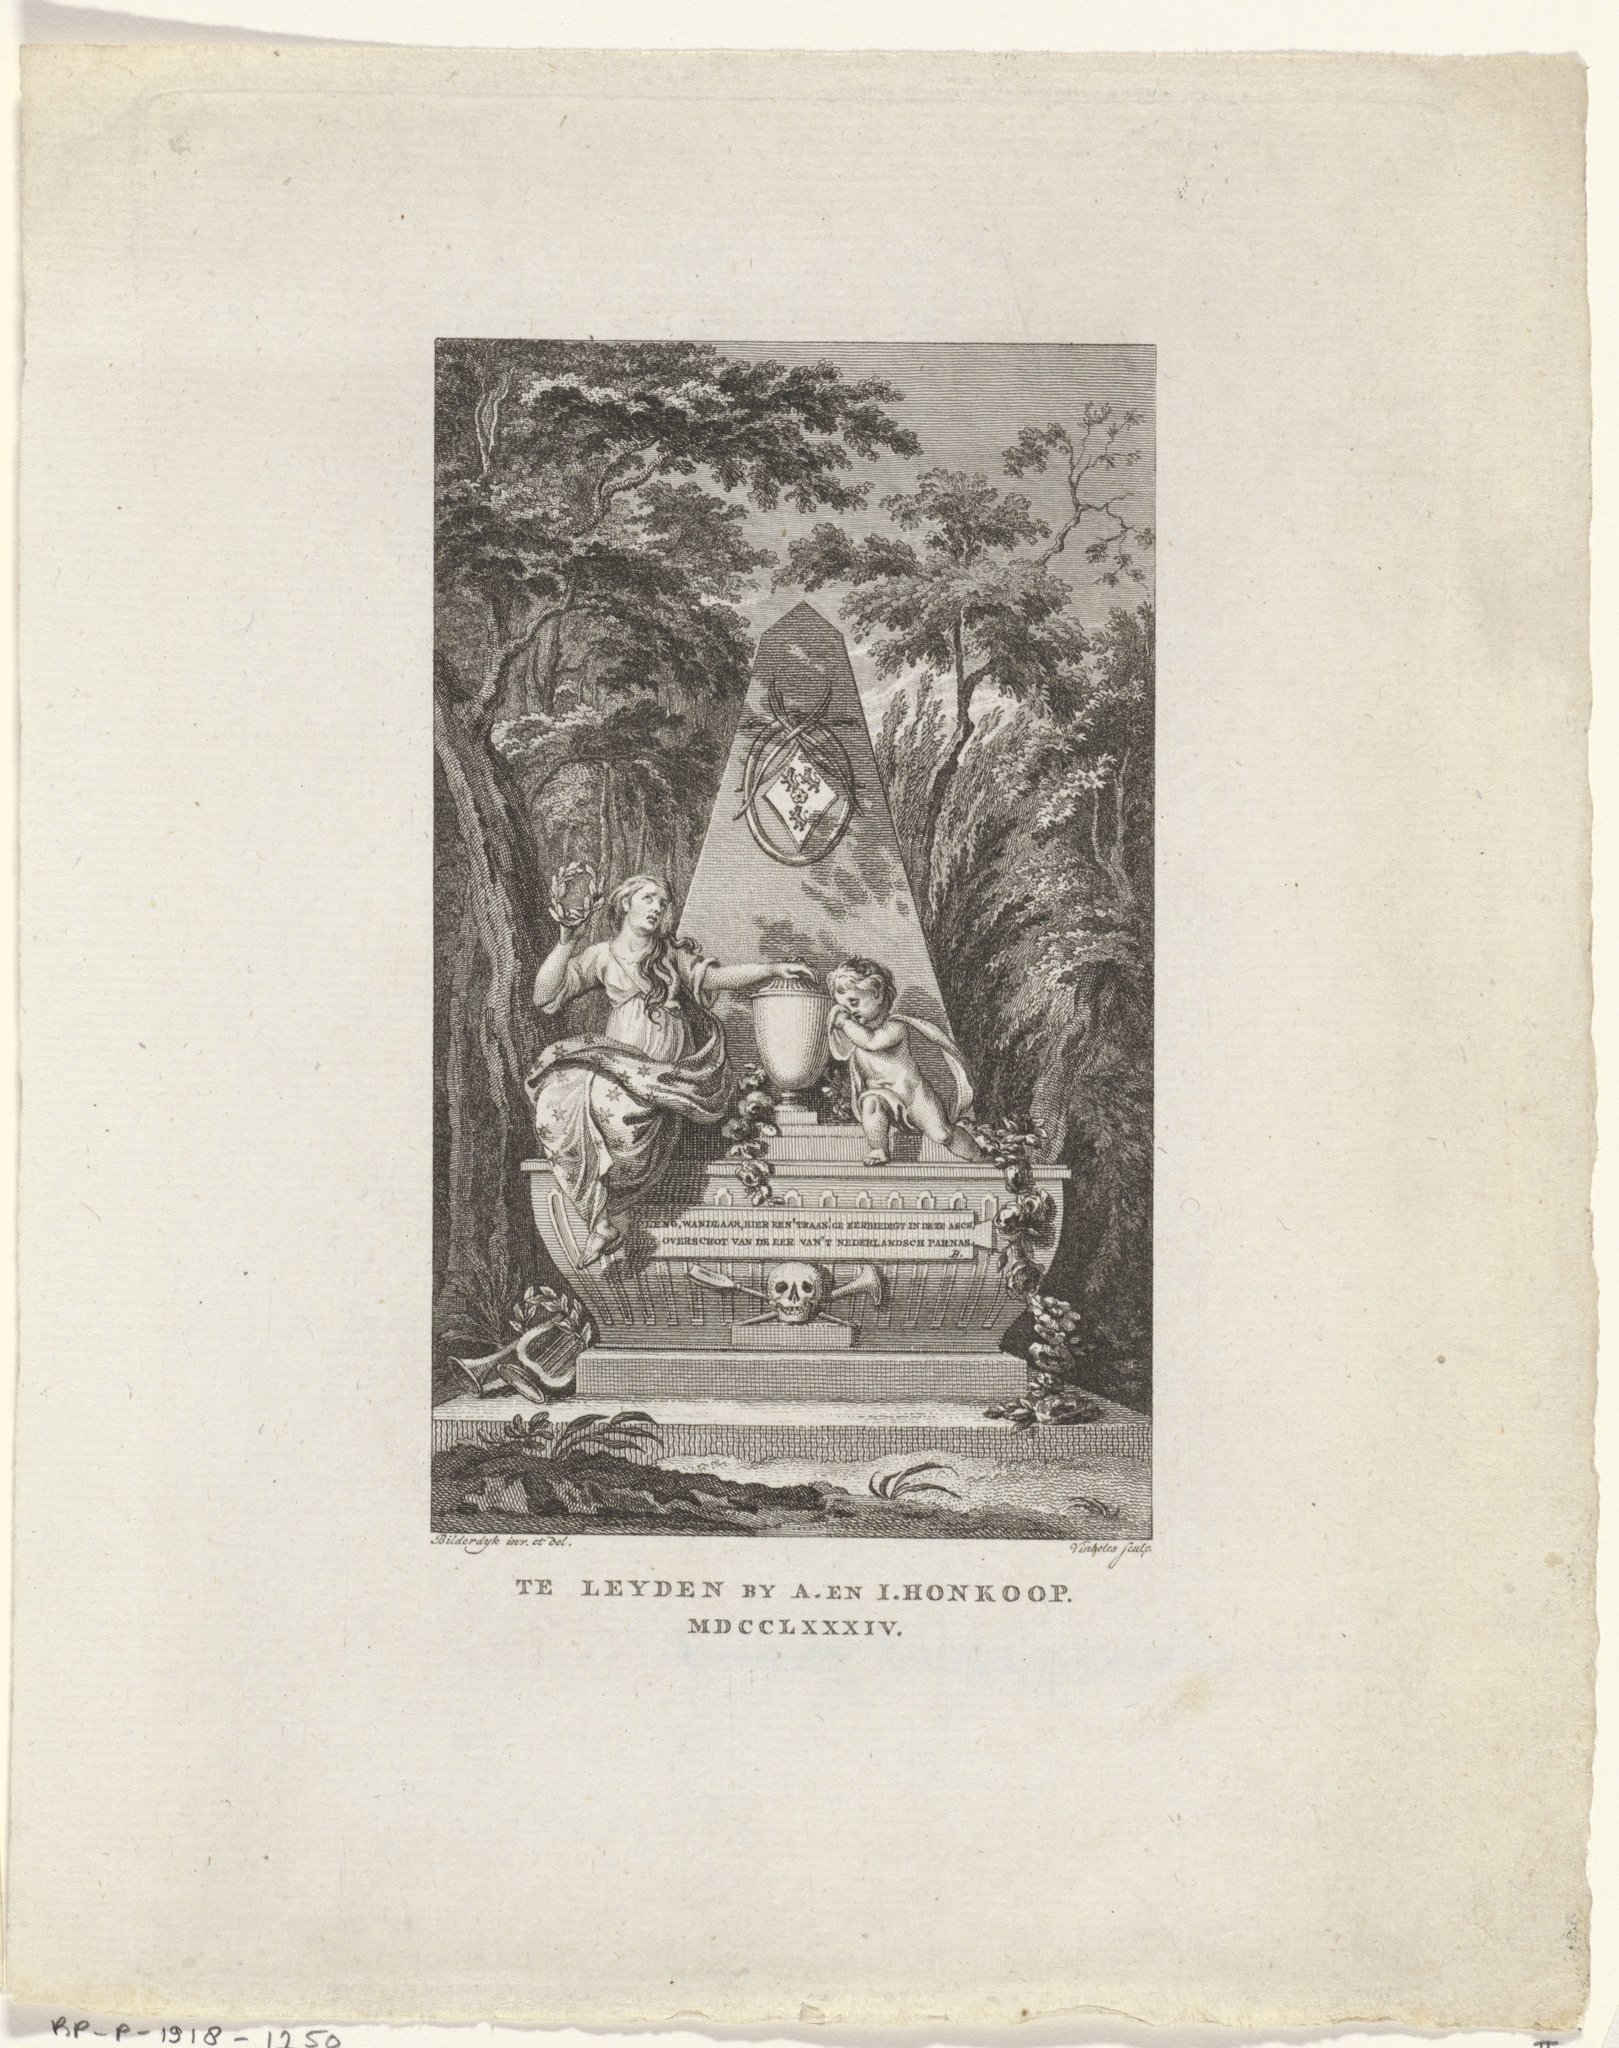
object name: print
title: Gedenkzuil voor Juliana Cornelia de Lannoy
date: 1784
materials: paper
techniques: engraving, etching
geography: amsterdam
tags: grave, tomb, forest, wood, mourning the dead, cupids: 'amores', 'amoretti', 'putti'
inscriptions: collector's mark: Lugt 2233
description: Gedenkzuil in een bos voor de dichteres Juliana Cornelia de Lannoy. Op het monument een huilende putto en een treurende vrouw.